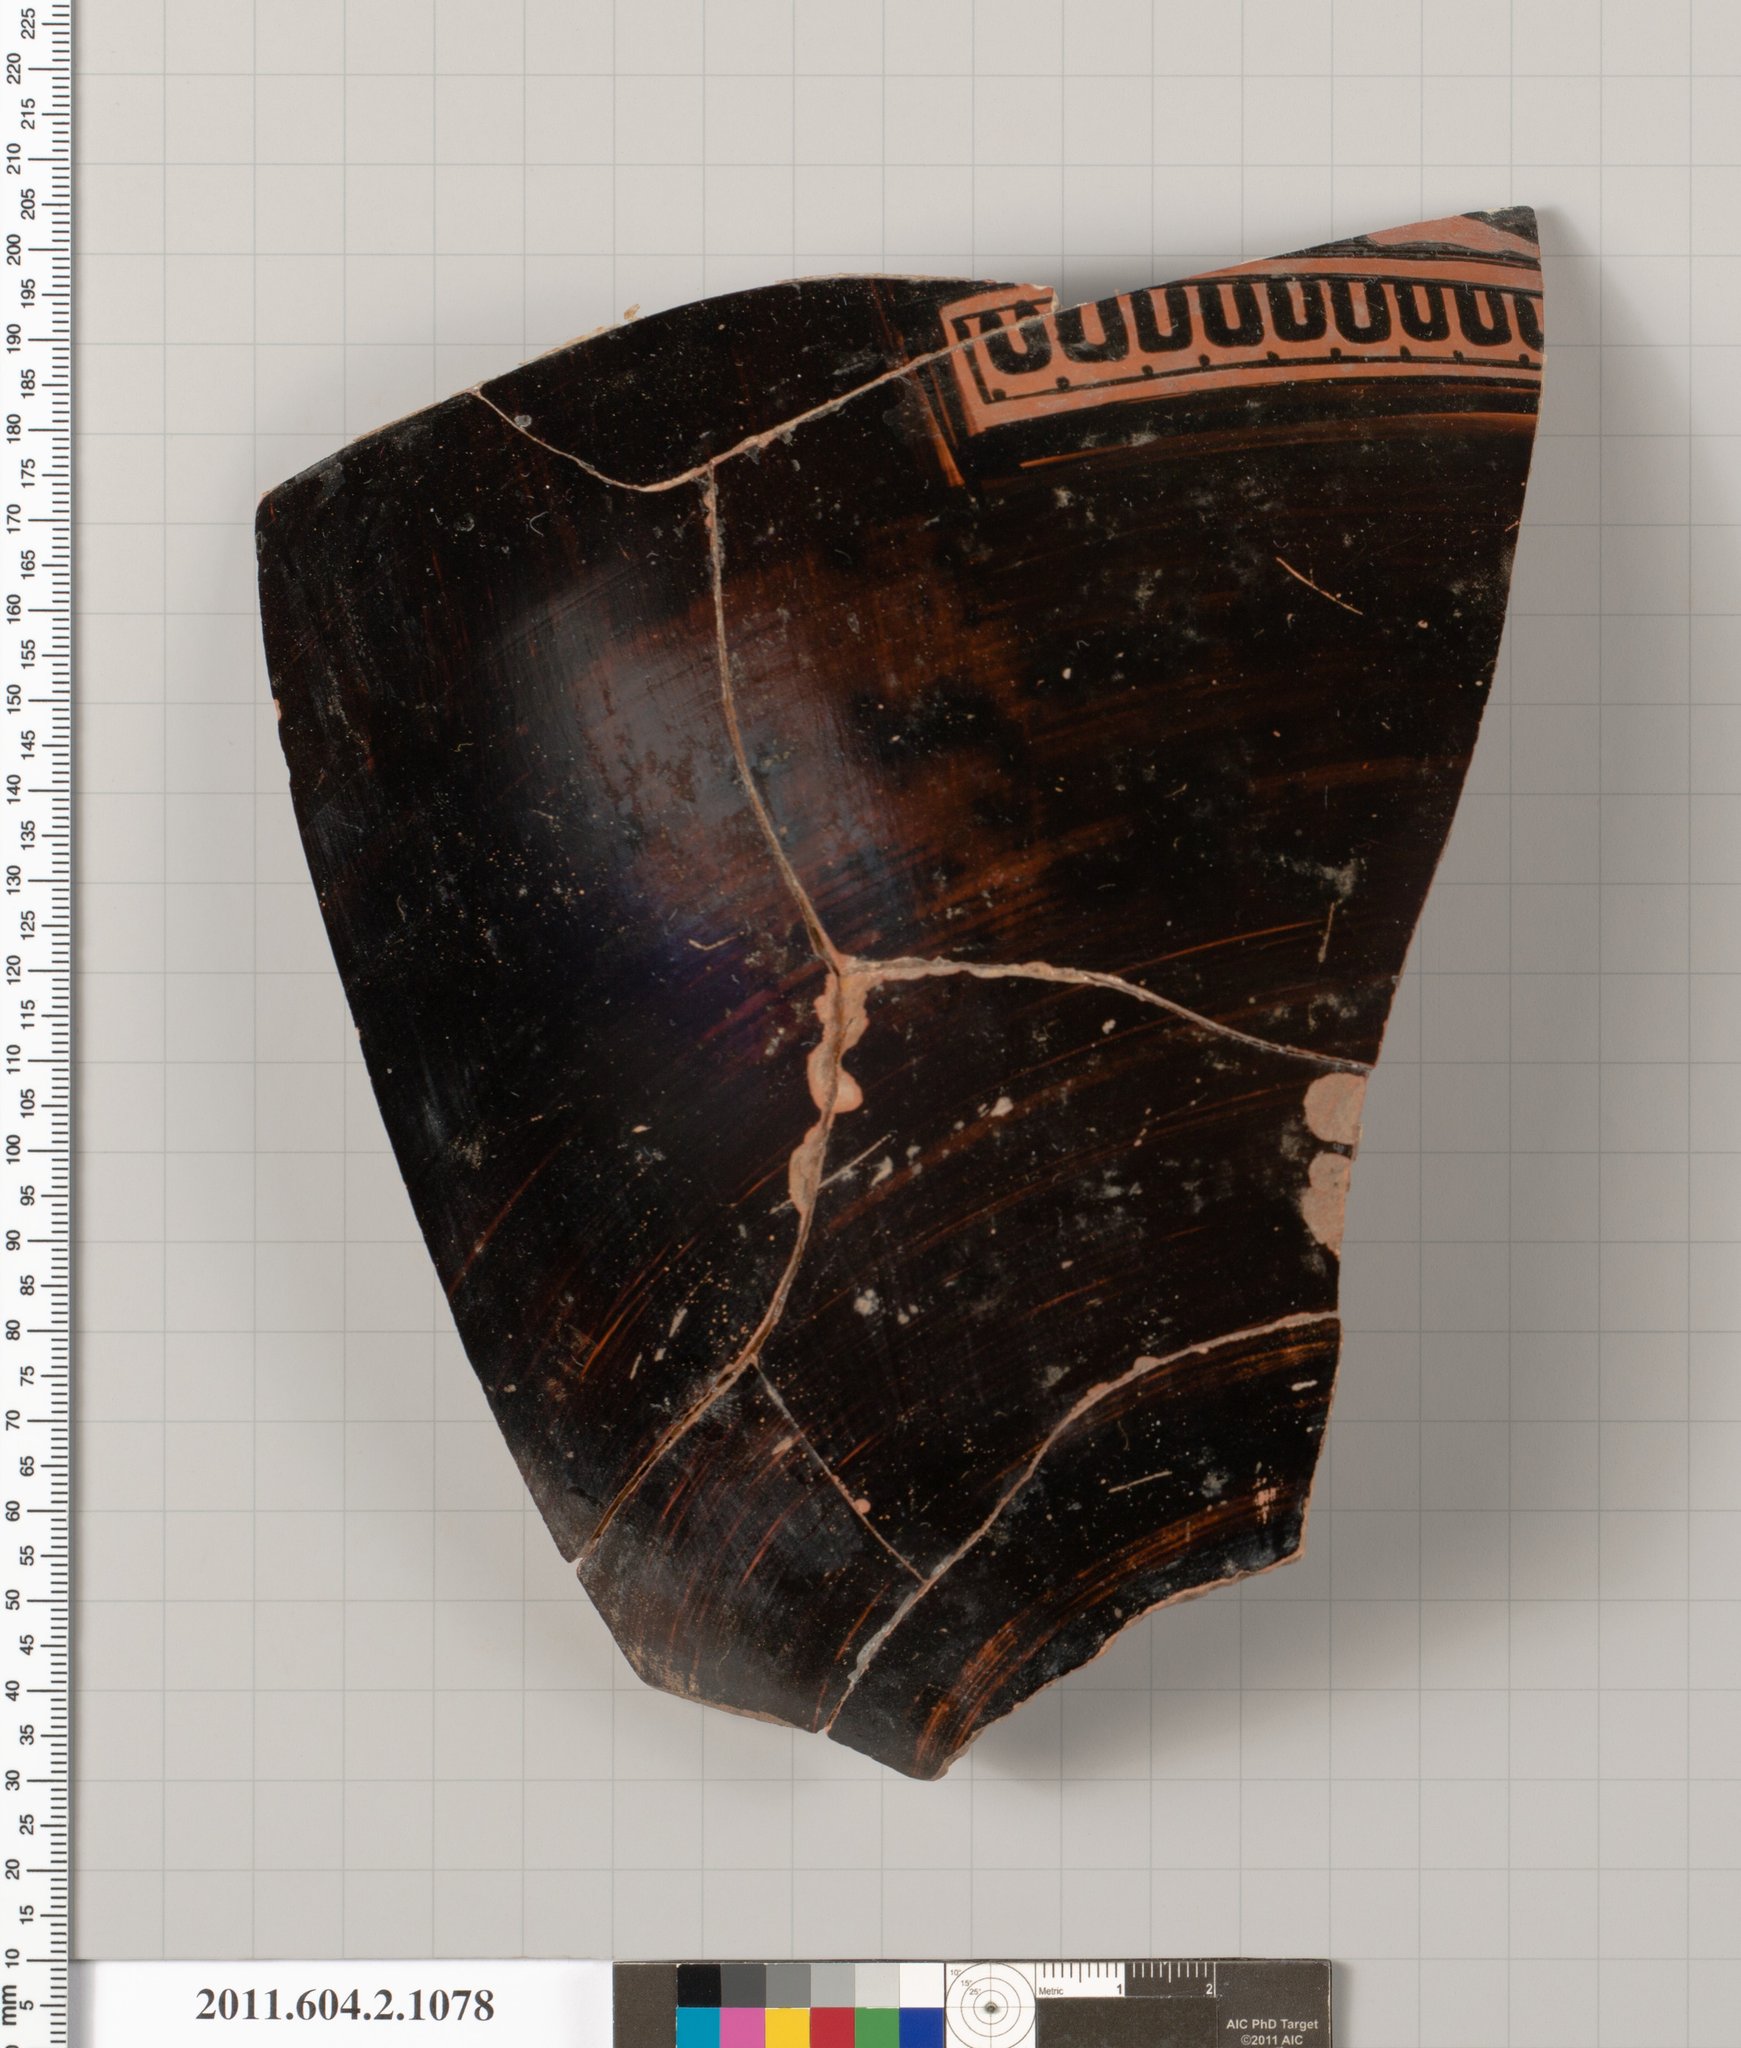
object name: hydria fragment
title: Terracotta fragment of a hydria (water jar)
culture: greek, attic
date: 534-468 BCE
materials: terracotta